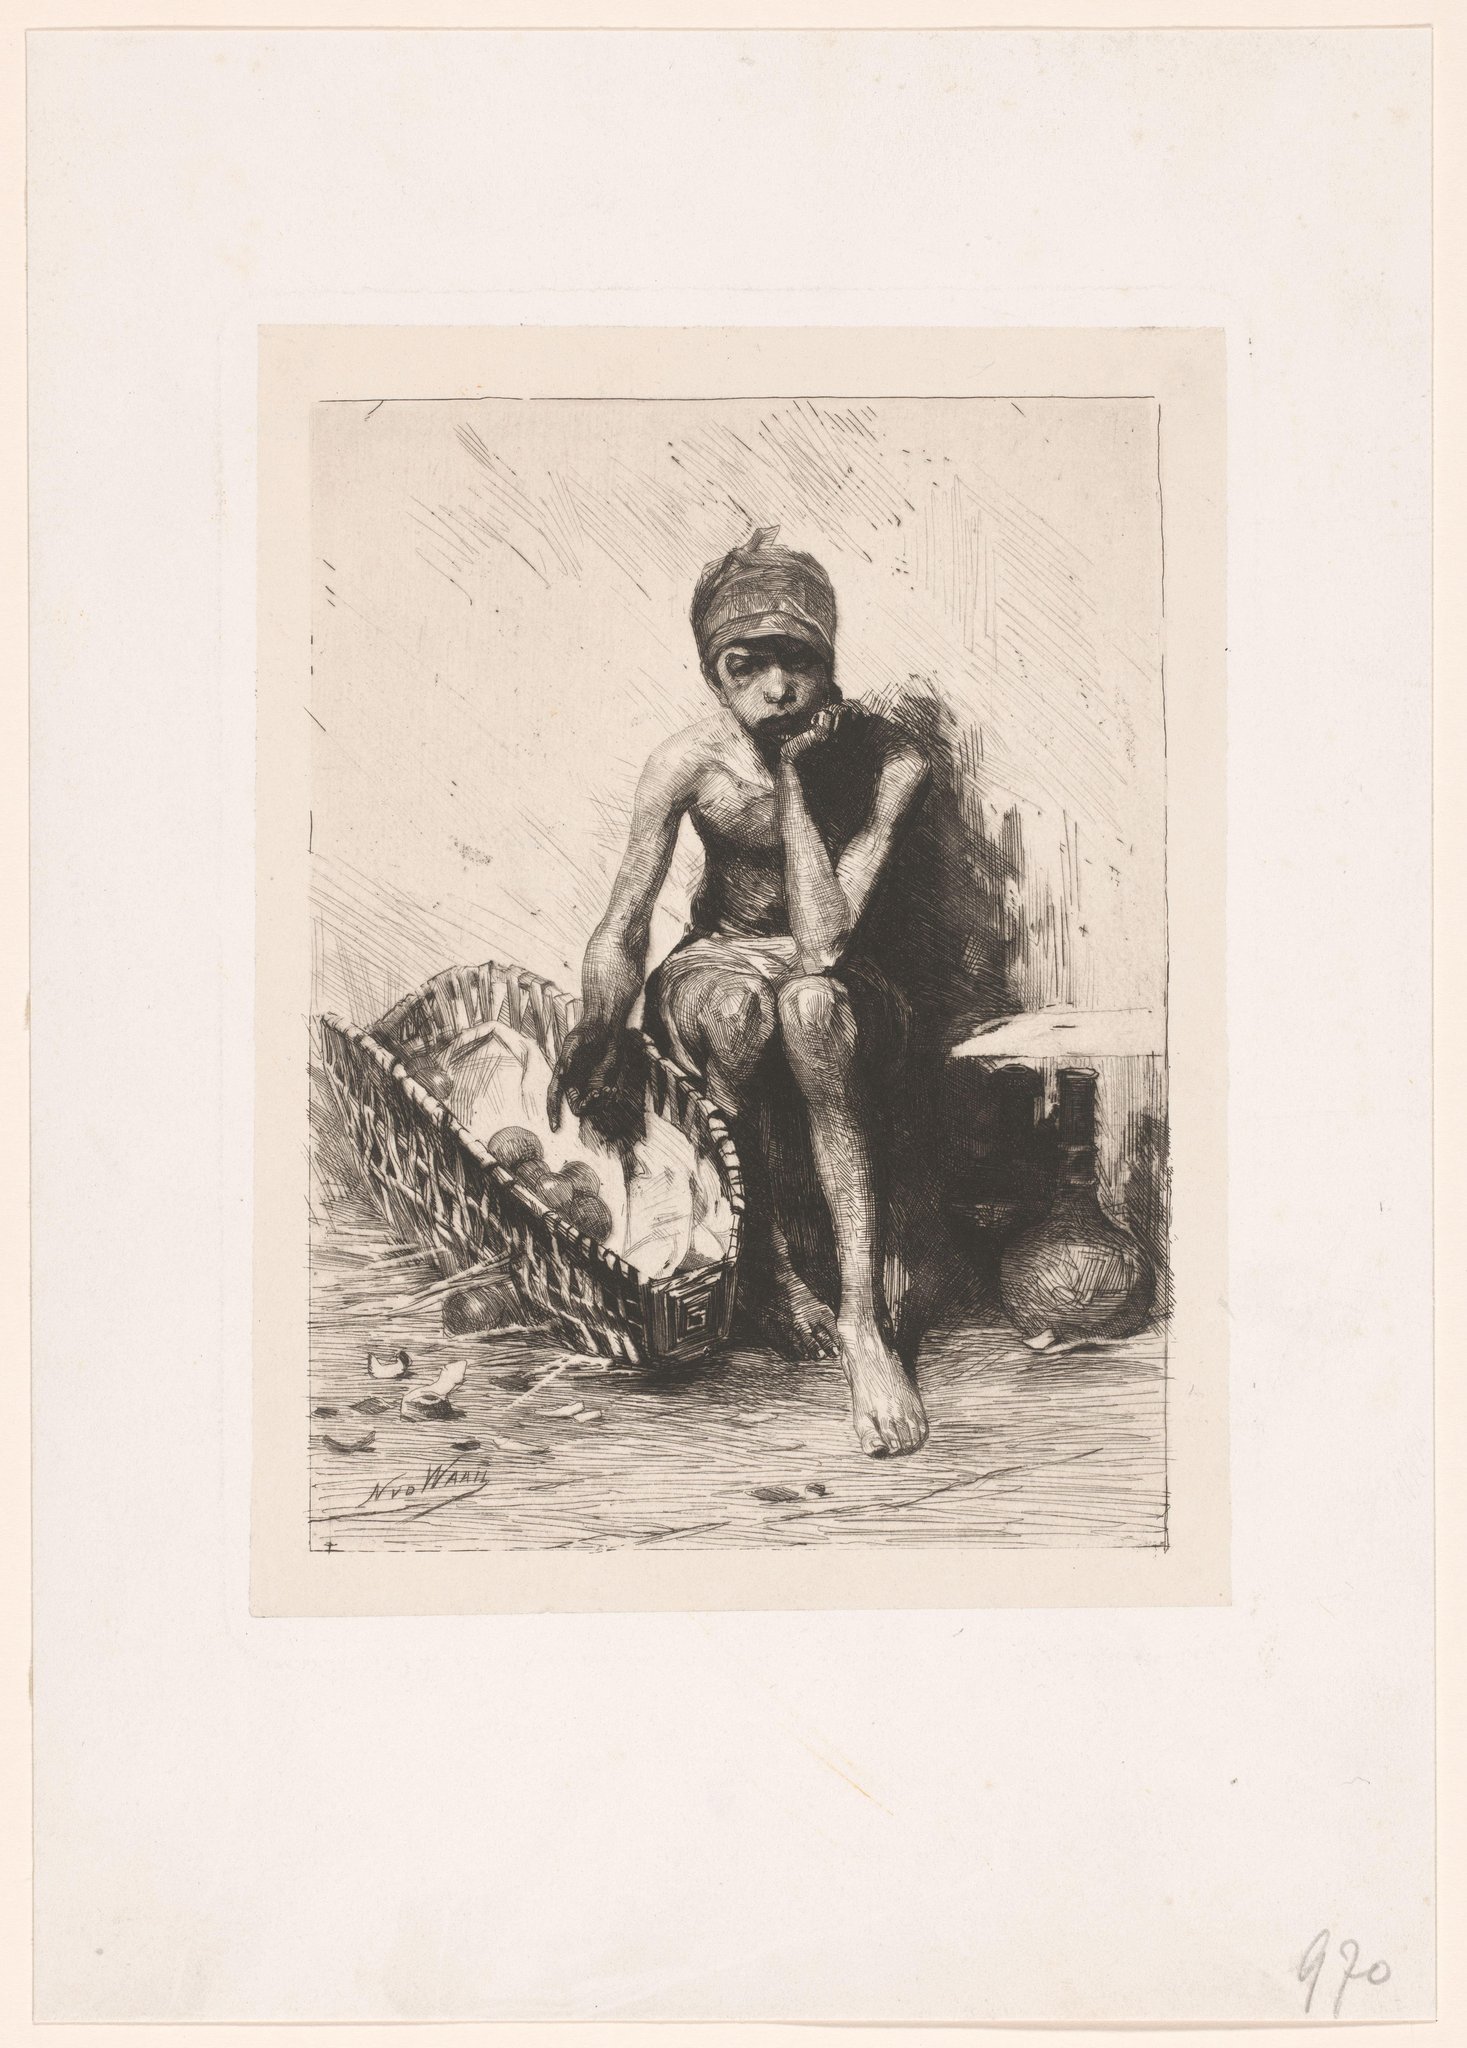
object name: print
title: Vruchtenverkoper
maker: nicolaas van der waay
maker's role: draughtsman, painter, print maker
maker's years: 1855-1936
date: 1865-1936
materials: paper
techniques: etching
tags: fruits, merchant, salesman, naples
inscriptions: inscription: ‘Staat zonder aquatint’, collector's mark: Lugt 2228, collector's mark: Lugt 2760